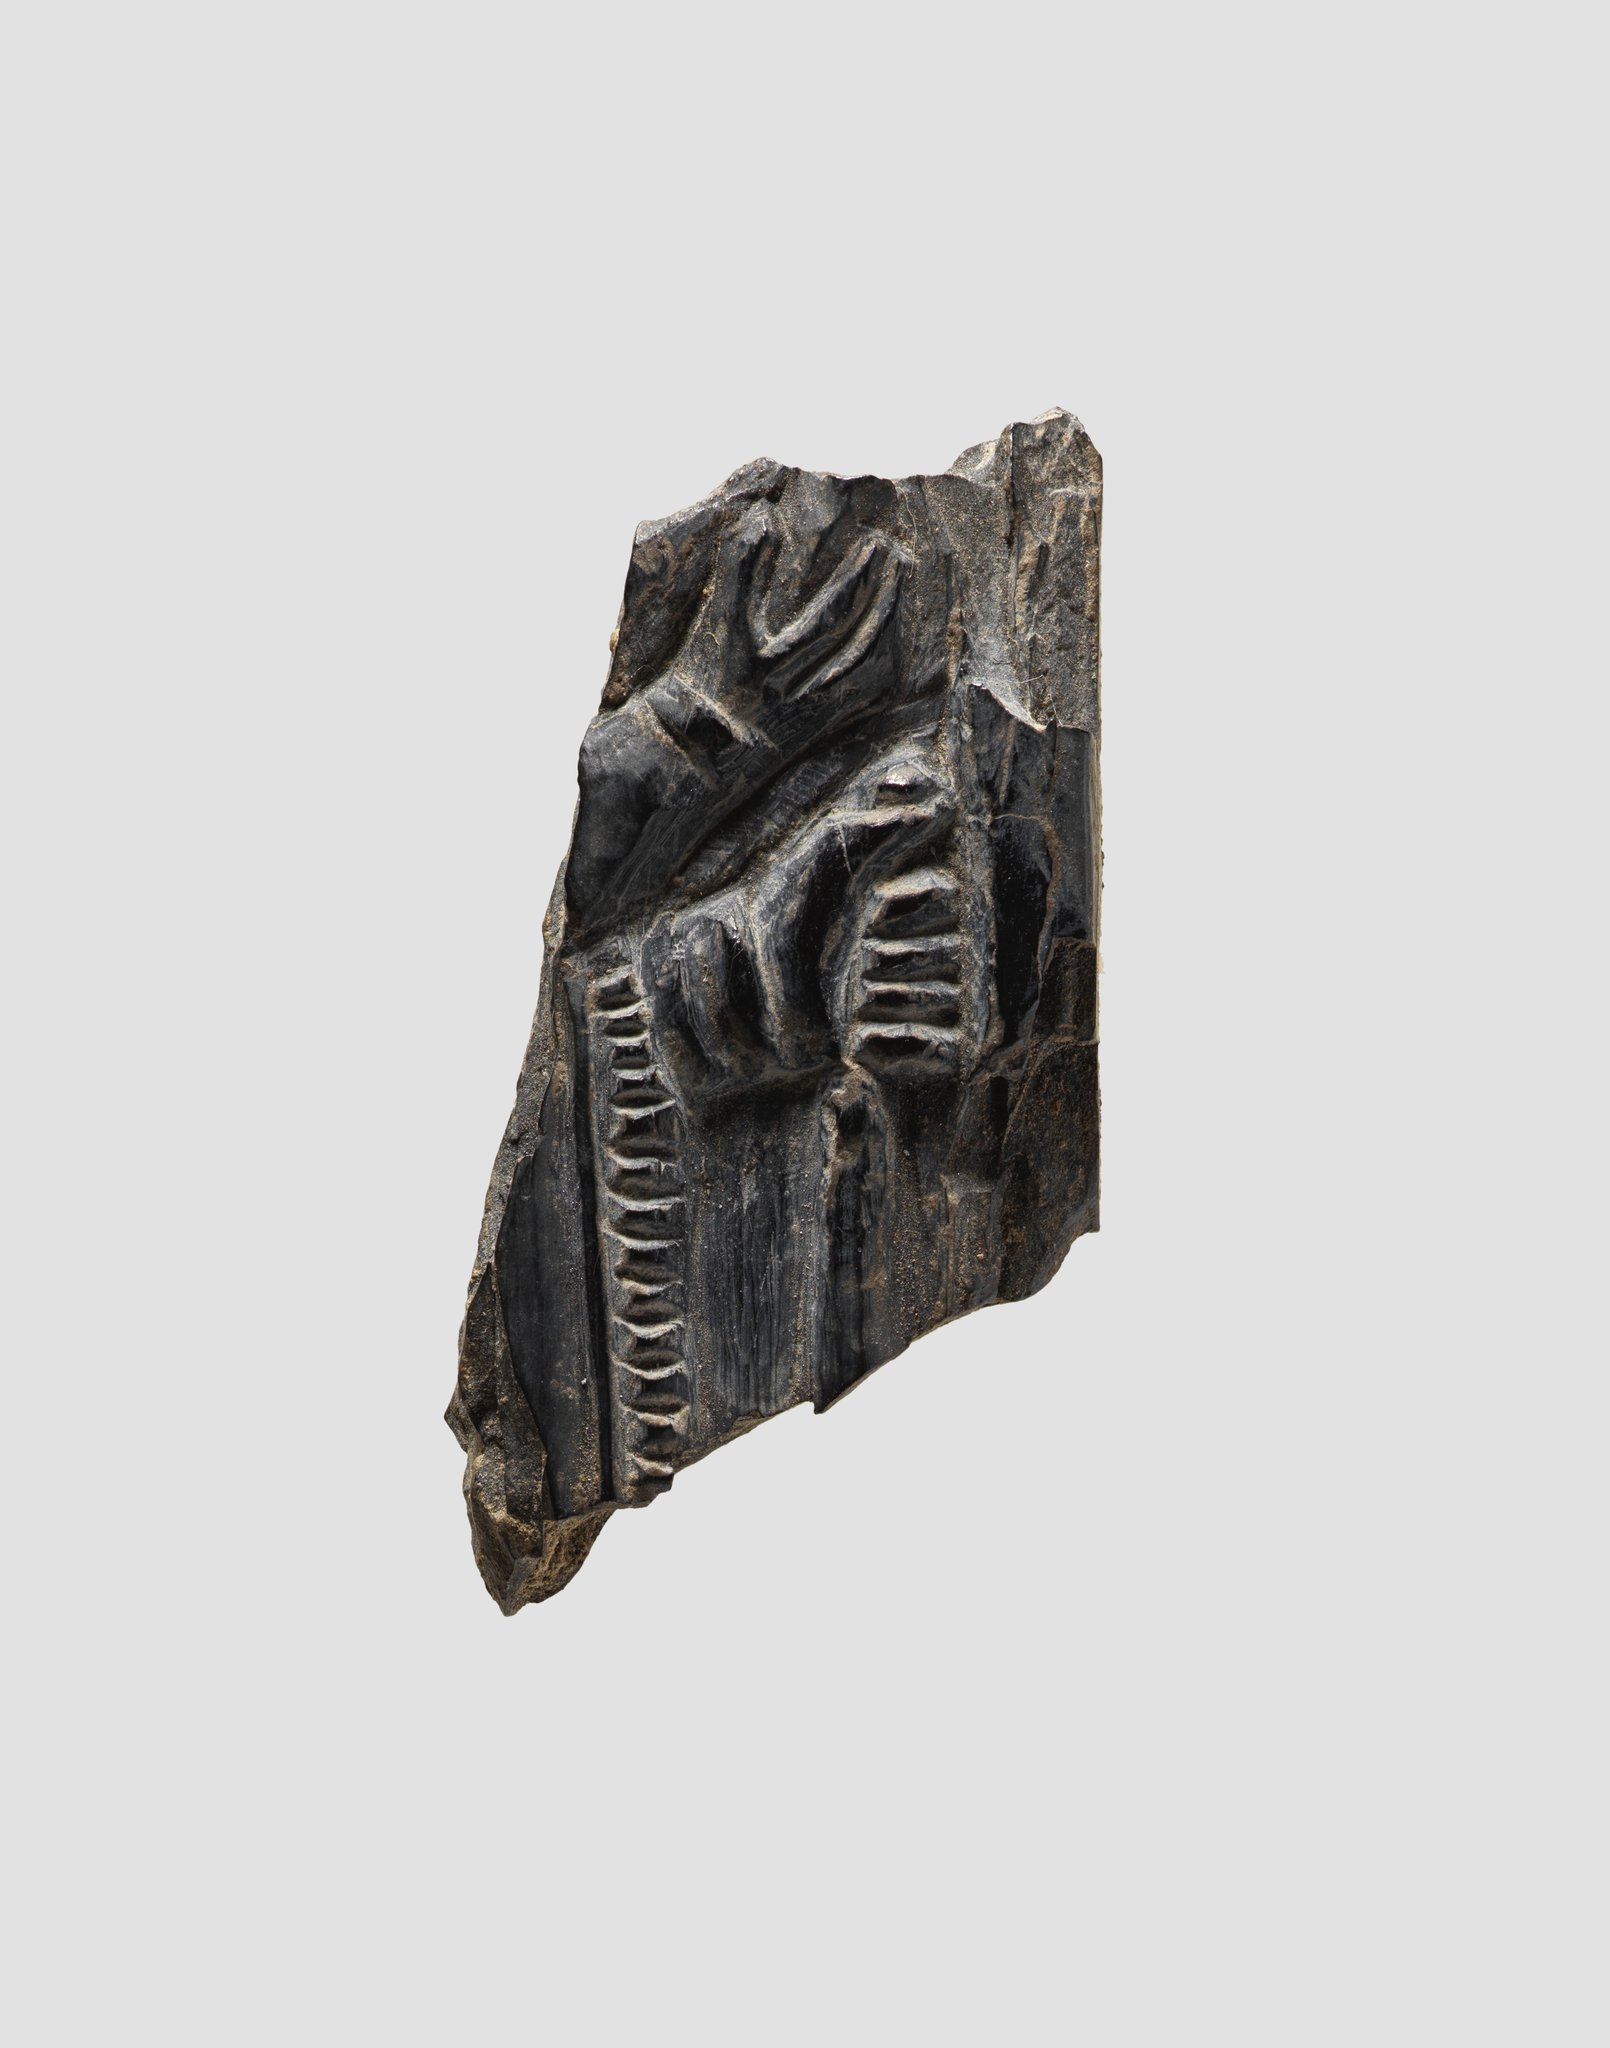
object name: relief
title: Plaque fragment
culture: iranian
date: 900-801 BCE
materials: ivory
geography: iran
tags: hands